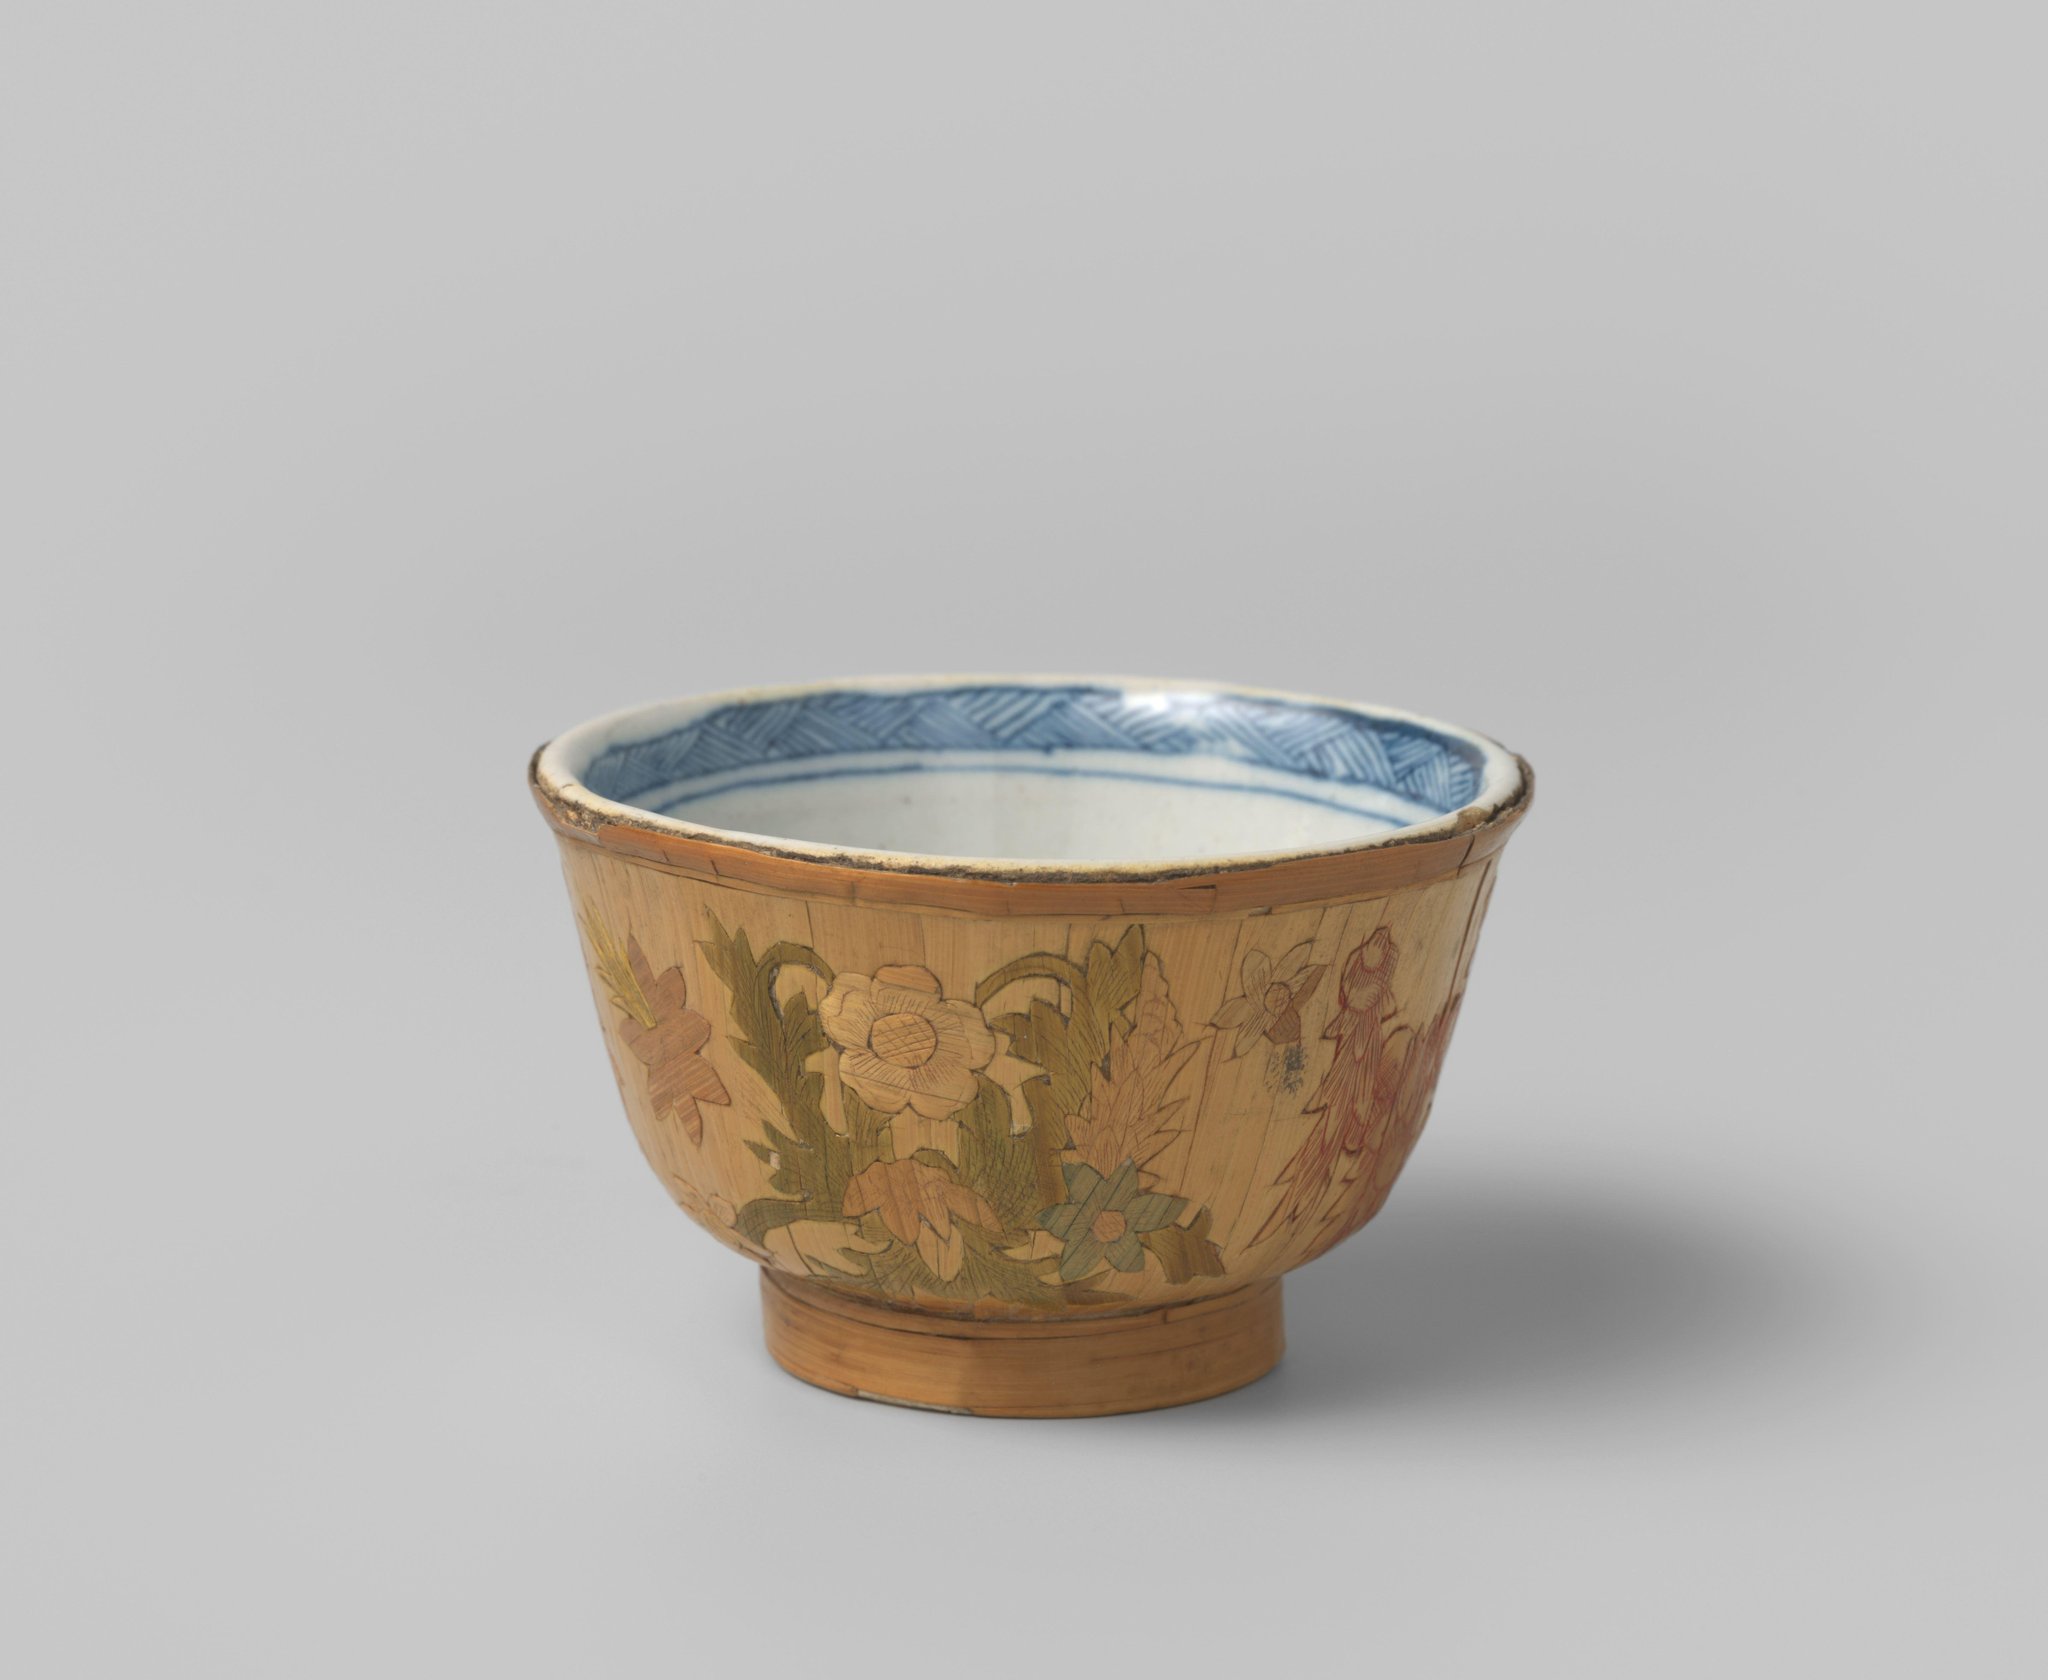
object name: kop en schotel, kop en schotel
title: Kop van faience en stro met bloemdecoratie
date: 1680-1710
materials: faience, straw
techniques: strohalm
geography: delft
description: Kop van faience en stro met een bloemen decoratie naar voorbeeld van het Chinese porselein uit de periode Wanli.